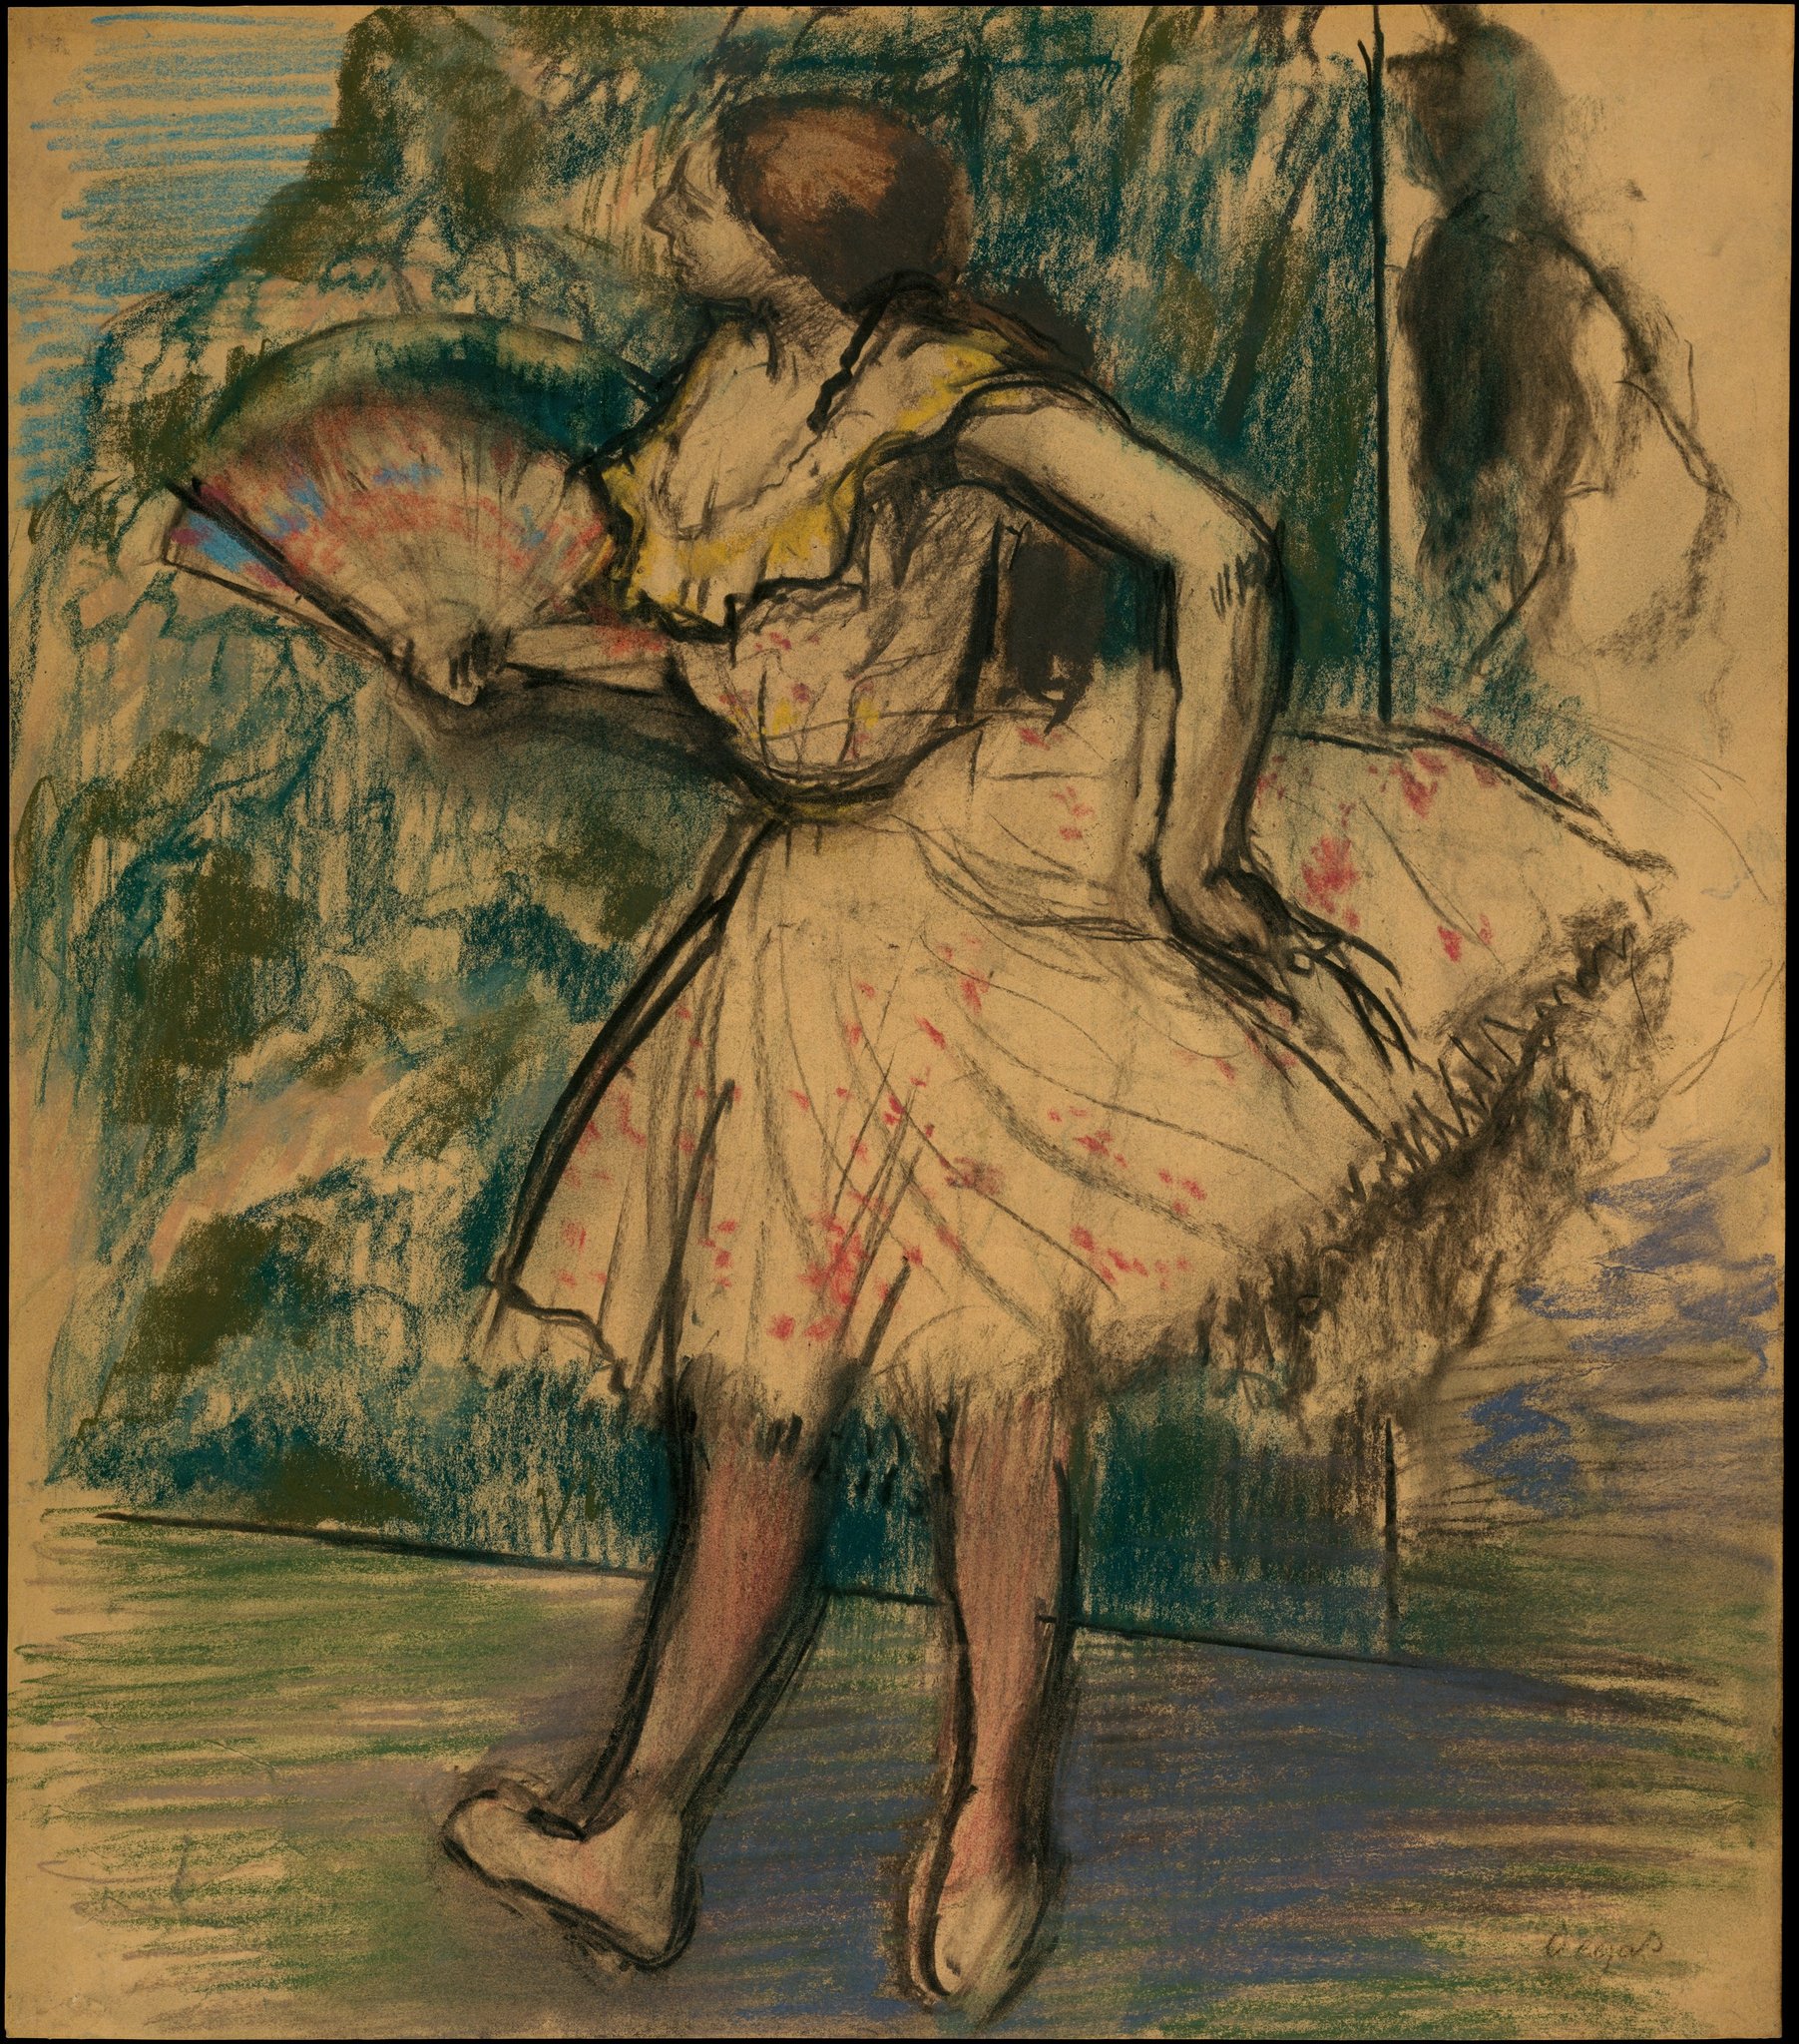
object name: drawing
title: Dancer with a Fan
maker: edgar degas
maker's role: artist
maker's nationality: french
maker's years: 1834-1917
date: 1890-1895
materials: charcoal, pastel, paper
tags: fans,women,dancers,ballet